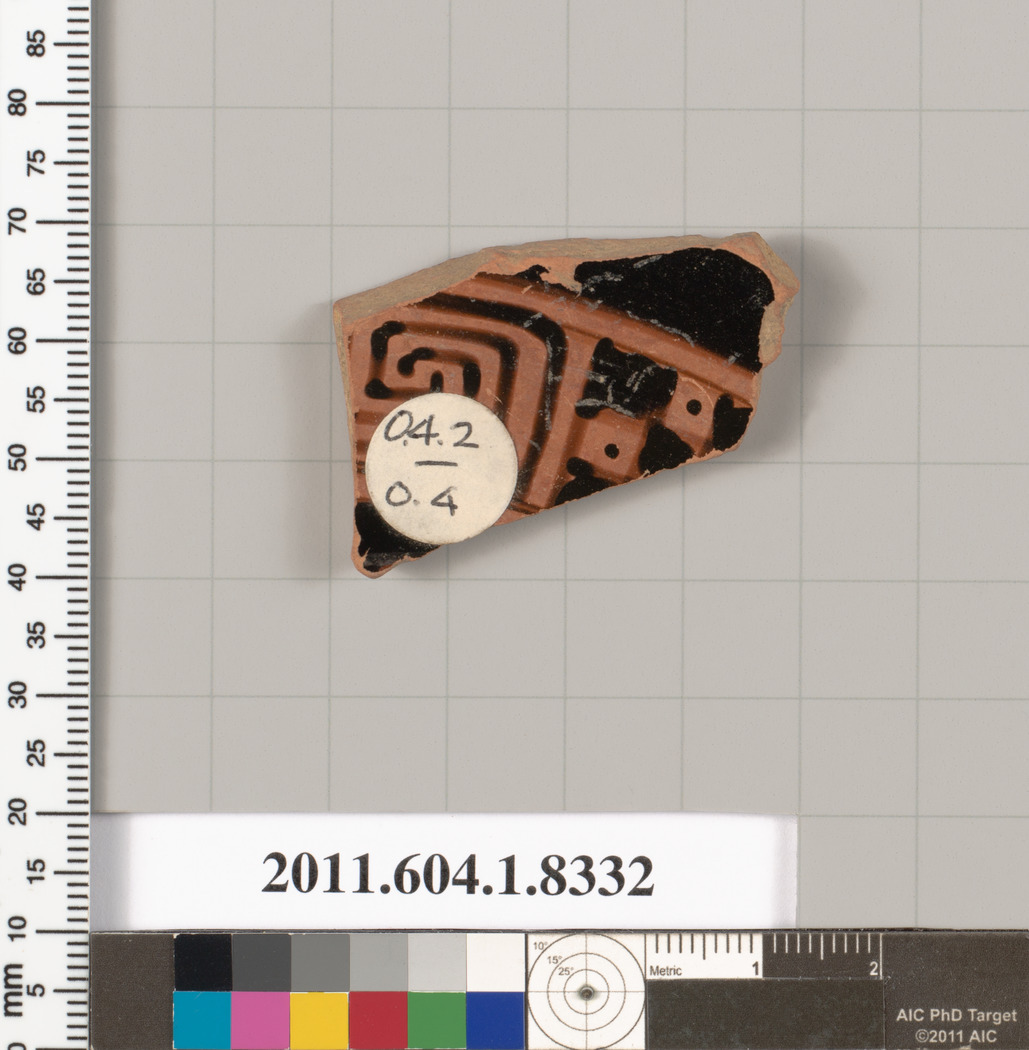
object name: kylix fragment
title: Terracotta fragment of a kylix (drinking cup)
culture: greek, attic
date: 400-351 BCE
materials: terracotta